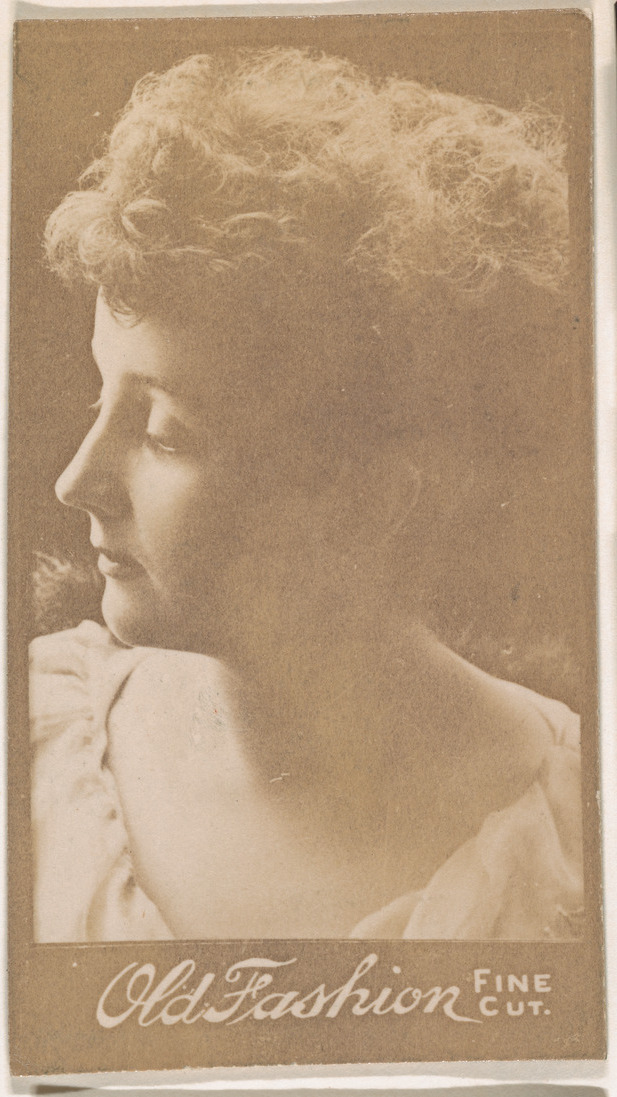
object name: photograph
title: Actress in profile, from the Actresses series (N664) promoting Old Fashion Fine Cut Tobacco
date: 1888-1890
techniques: albumen silver print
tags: portraits,women,actresses